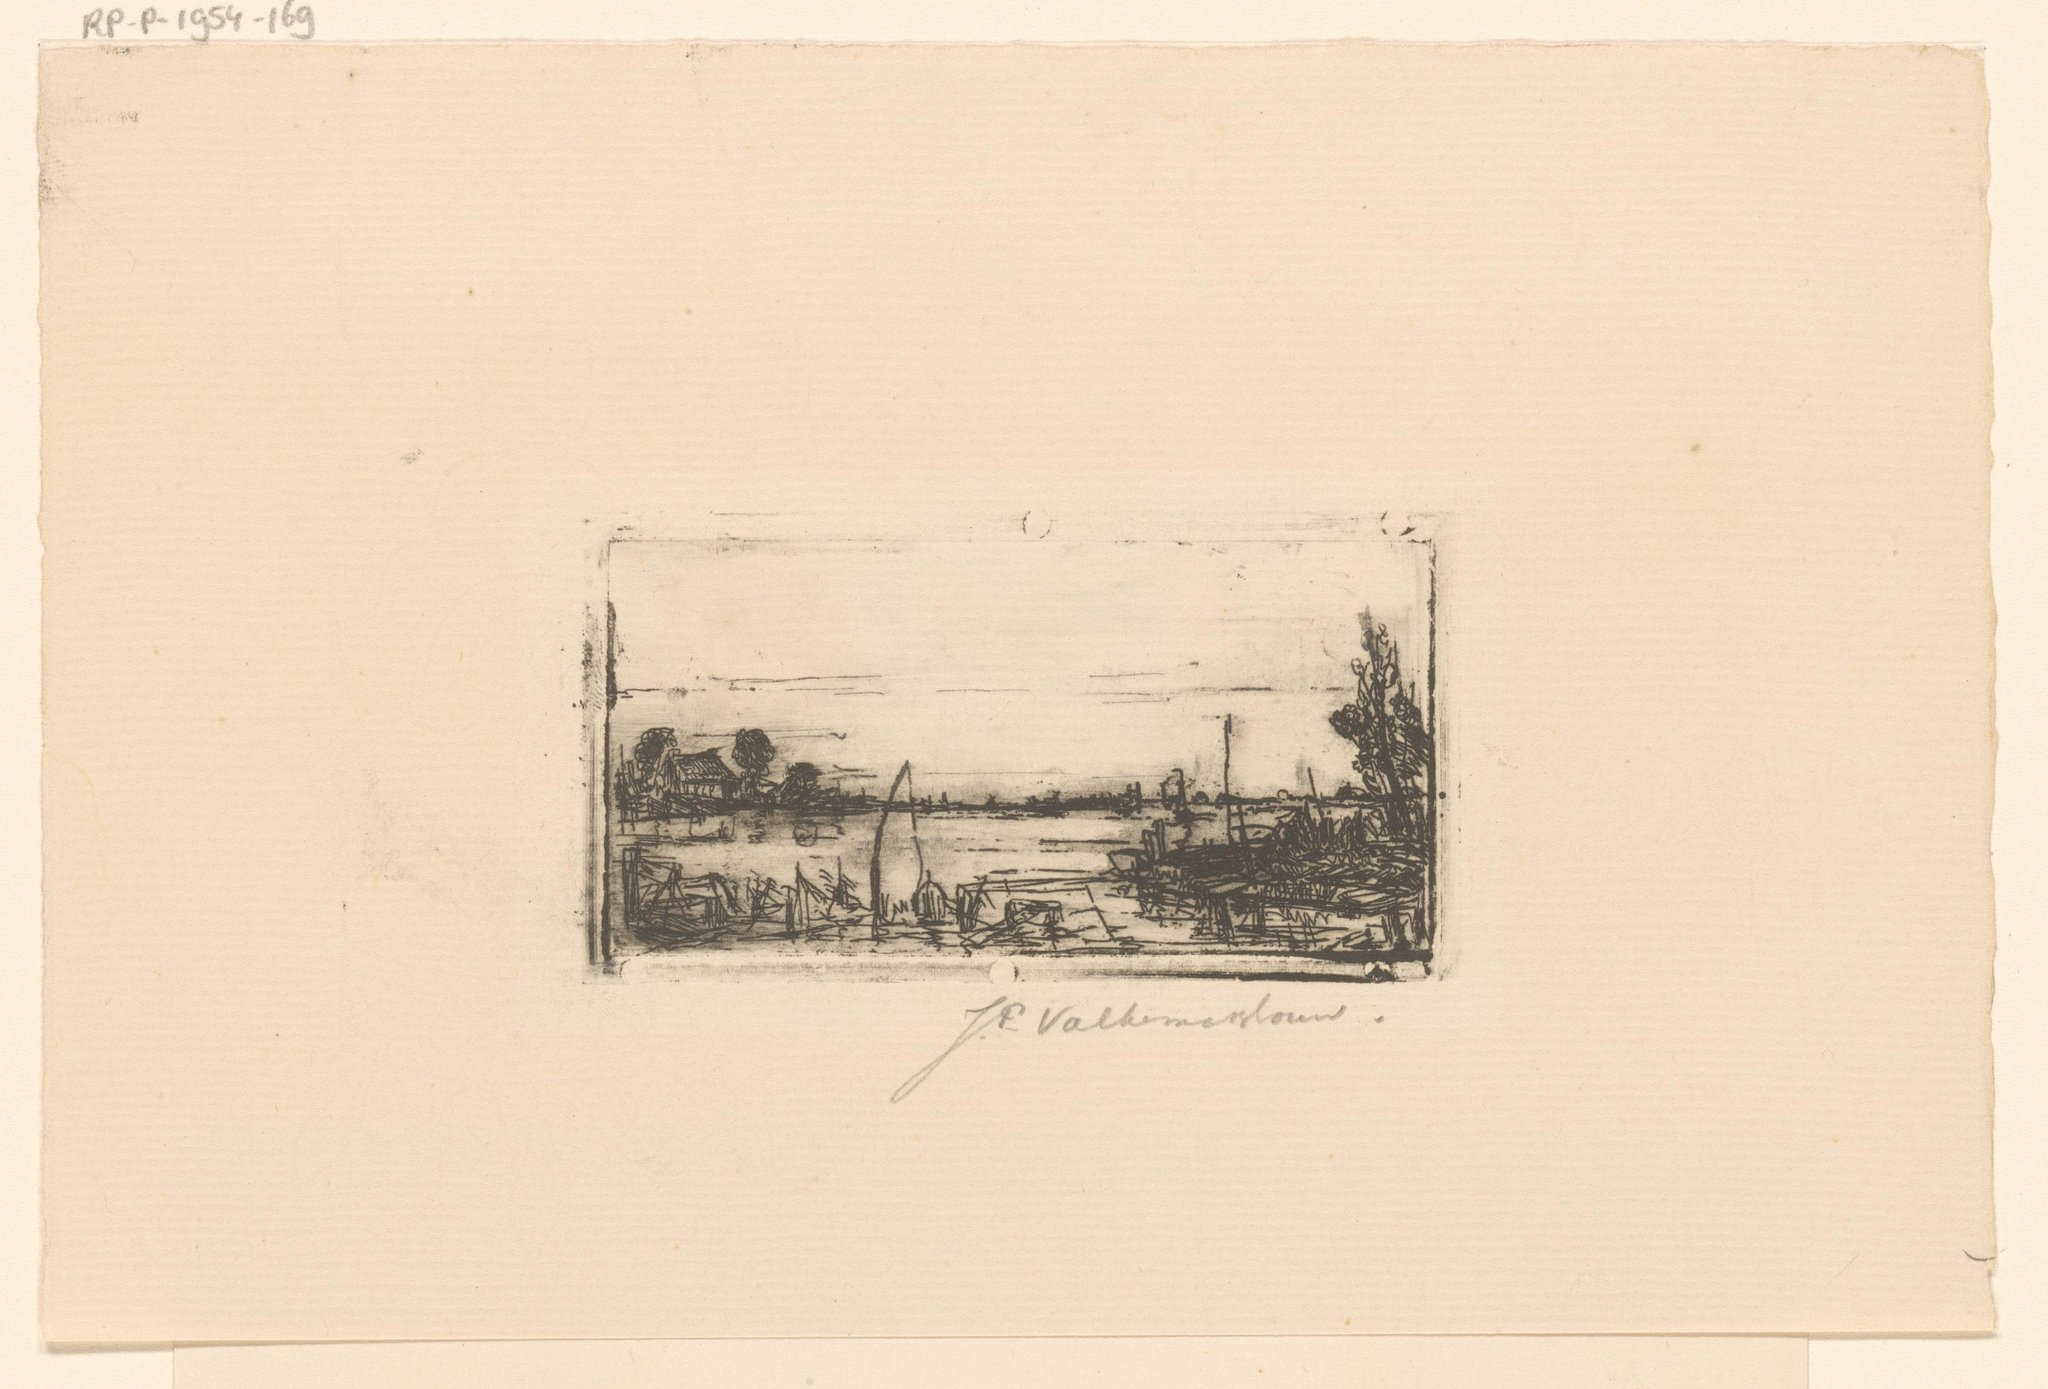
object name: print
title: Gezicht op een meer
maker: jan paul valkema blouw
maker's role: draughtsman, print maker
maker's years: 1884-1954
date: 1916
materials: paper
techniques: etching, intaglio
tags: lake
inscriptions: collector's mark: Lugt 2228, collector's mark: Lugt 2760